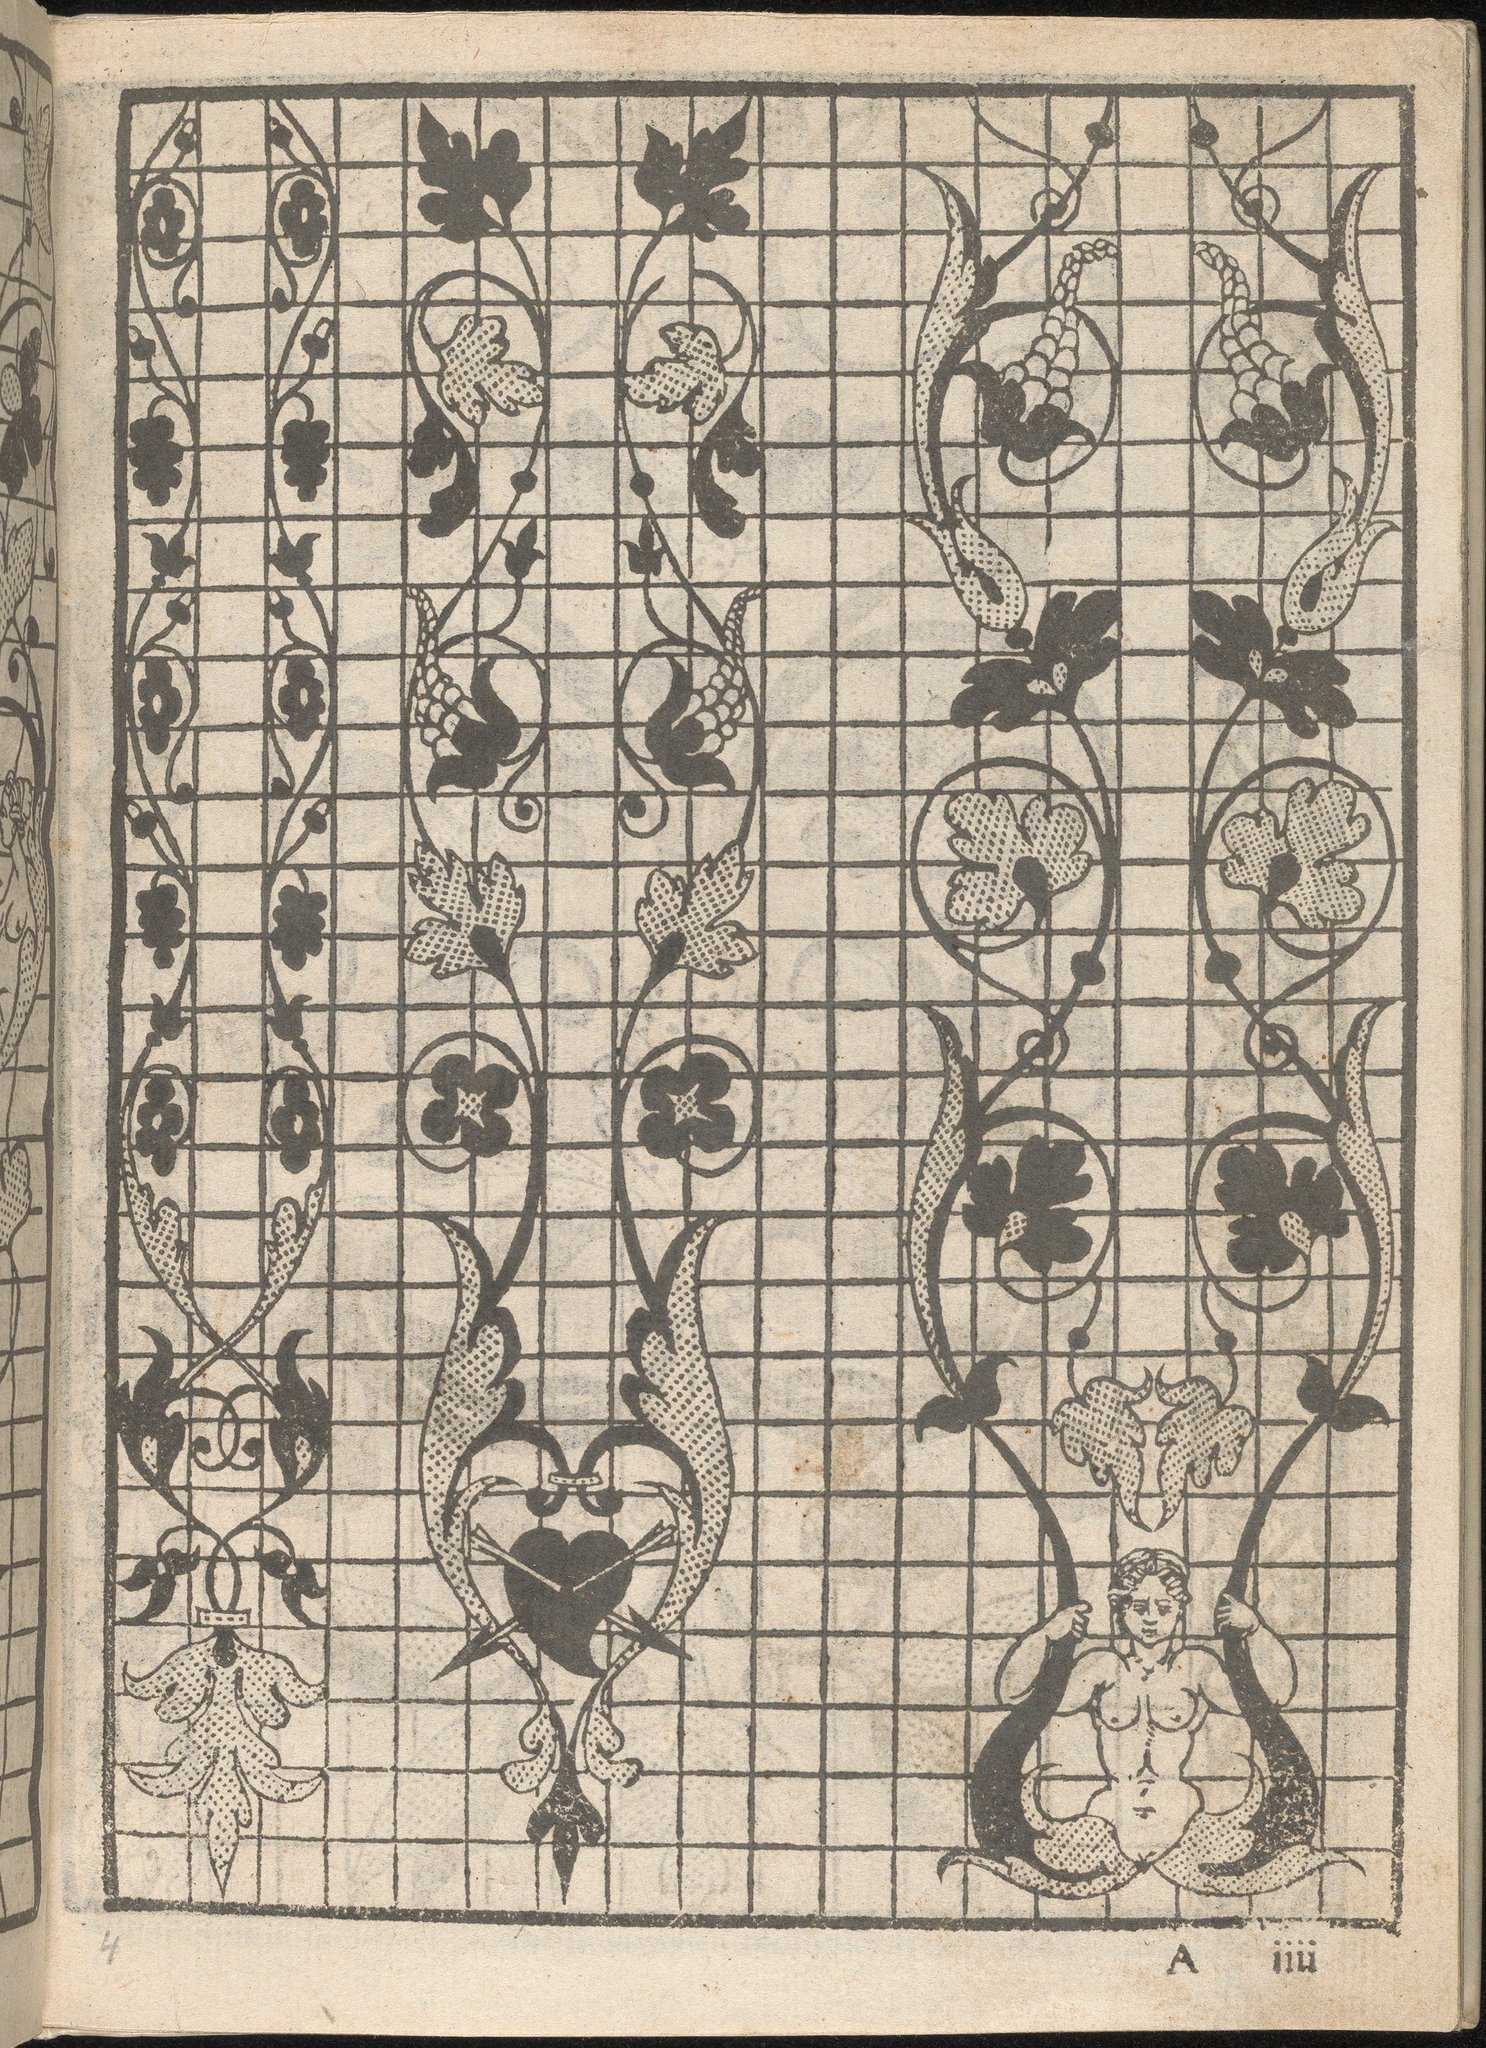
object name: book print ornament architecture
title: Splendore delle virtuose giovani, page 2 (verso)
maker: iseppo foresto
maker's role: designer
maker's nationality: italian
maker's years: 1520-1580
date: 1564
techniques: woodcut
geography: italy